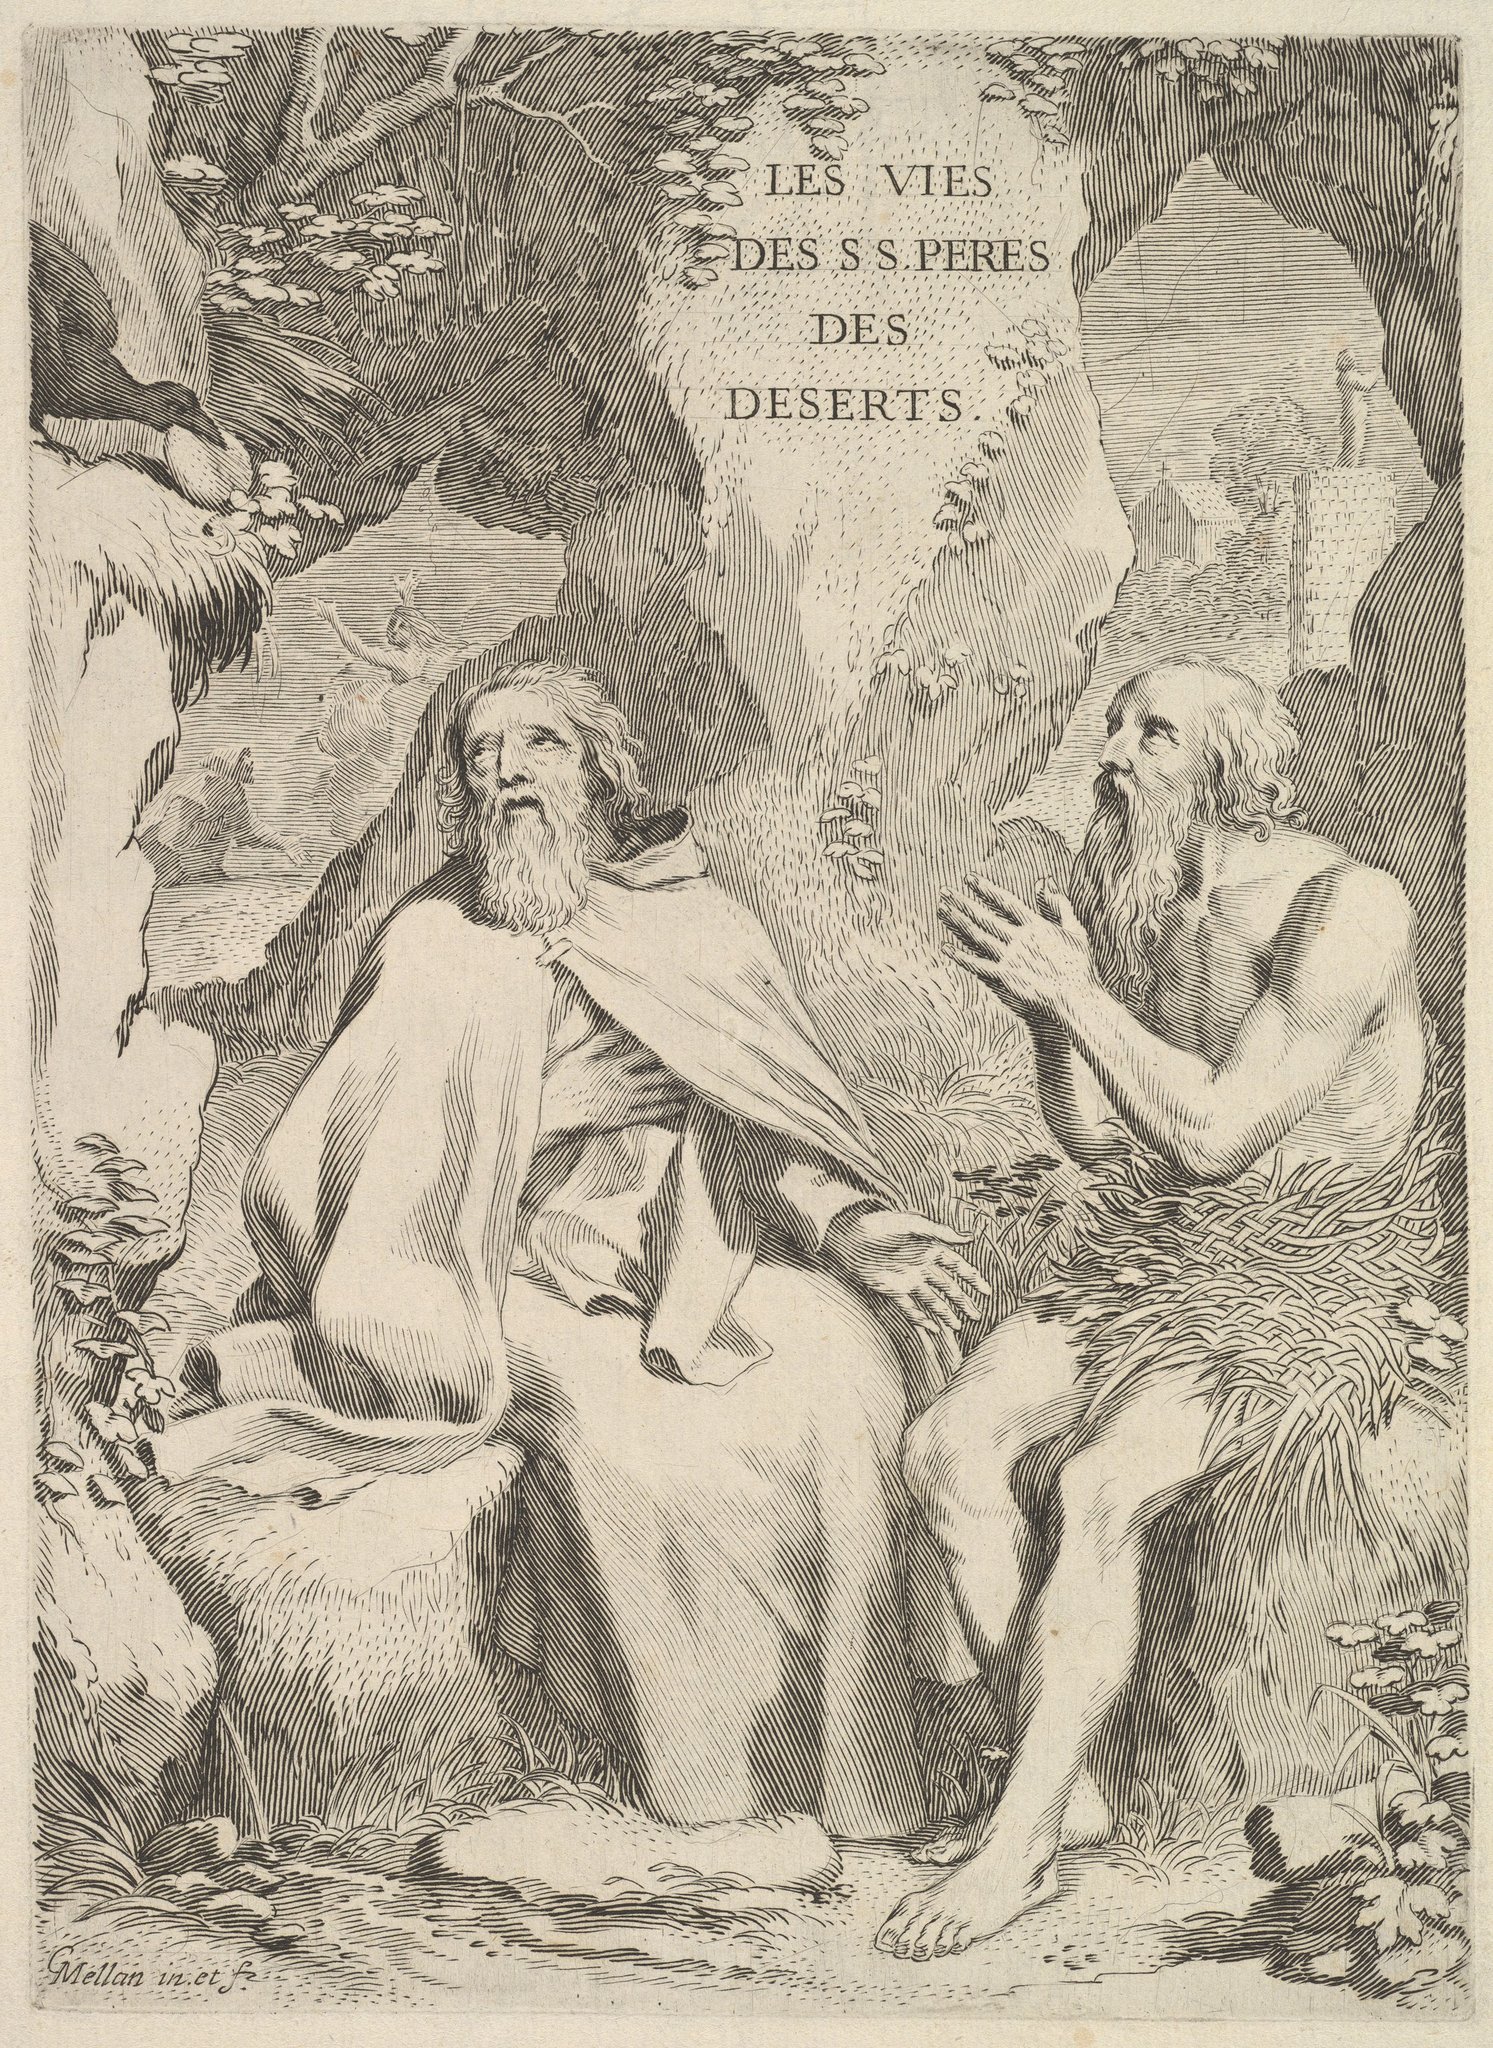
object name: print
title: Title page: Arnaud d'Andilly, Les Vies des saints pères des déserts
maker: claude mellan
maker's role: artist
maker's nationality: french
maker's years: 1598-1688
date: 1647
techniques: engraving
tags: men,saints